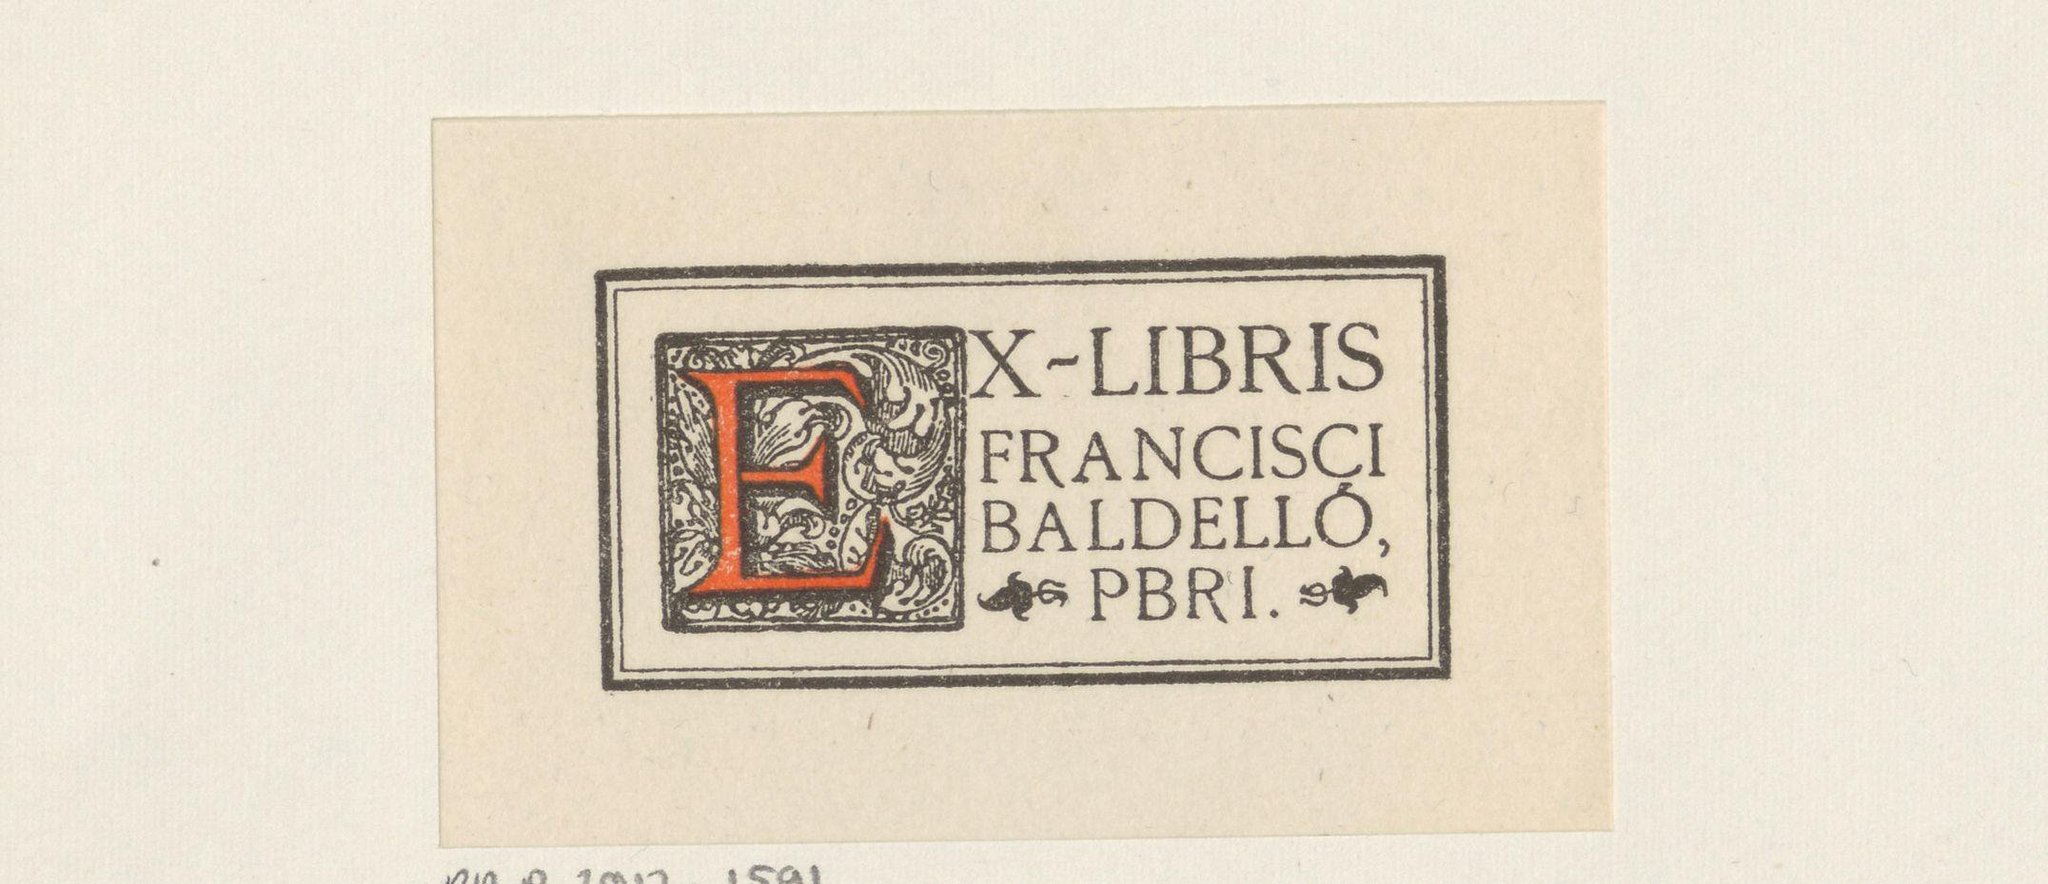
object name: bookplate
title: Ex libris van Francisco Baldelló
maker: Anonymous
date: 1900-1999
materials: paper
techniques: printing block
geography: italy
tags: francisco baldelló